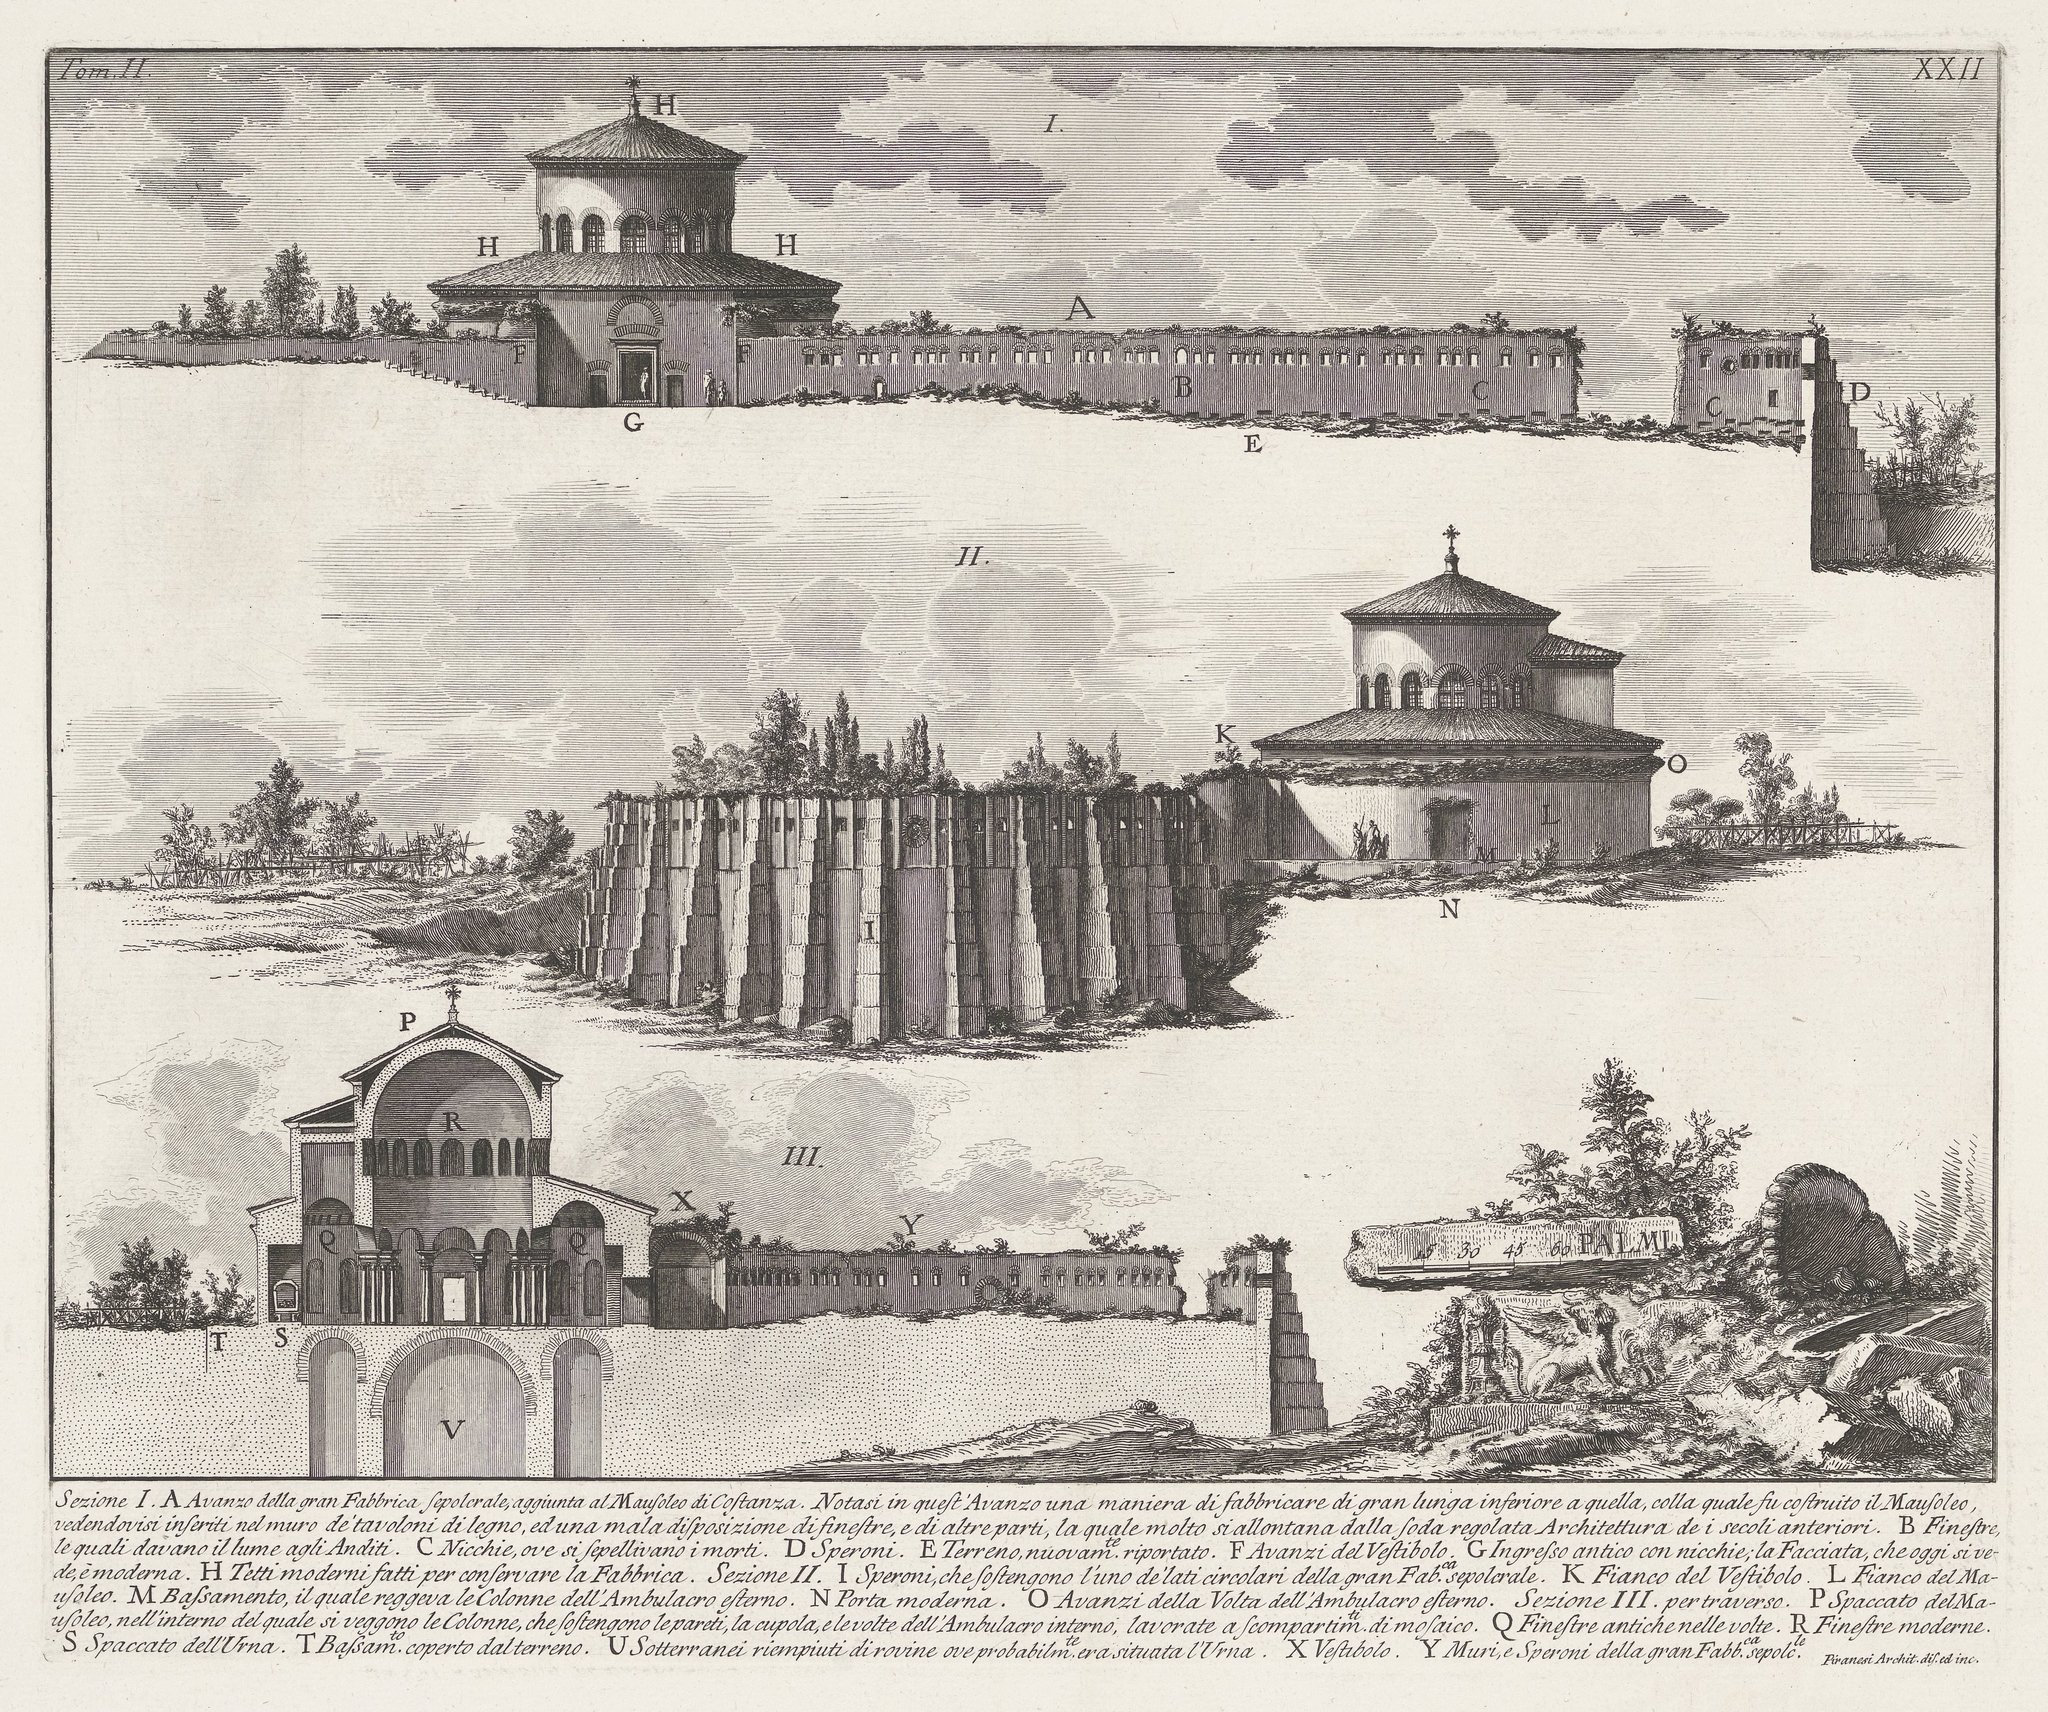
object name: print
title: Archeologische vondsten in en rond Rome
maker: giovanni battista piranesi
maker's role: designer, draughtsman, print maker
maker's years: 1720-1778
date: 1756-1757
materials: paper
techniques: etching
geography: rome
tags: church (exterior), roman catholic church, interior of church, rome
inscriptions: collector's mark: Lugt 2228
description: Deze prent maakt deel uit van de serie 'Le Antichità Romane'. Piranesi deed meer dan acht jaar voorstudie voor deze 250 platen tellende serie die in vier volumes werd uitgegeven. Hij produceerde de prenten tussen ca. 1756 en 1757. De serie bevat ook prenten door of naar andere prentmakers, onder wie Francesco Bianchini en Girolamo Rossi.